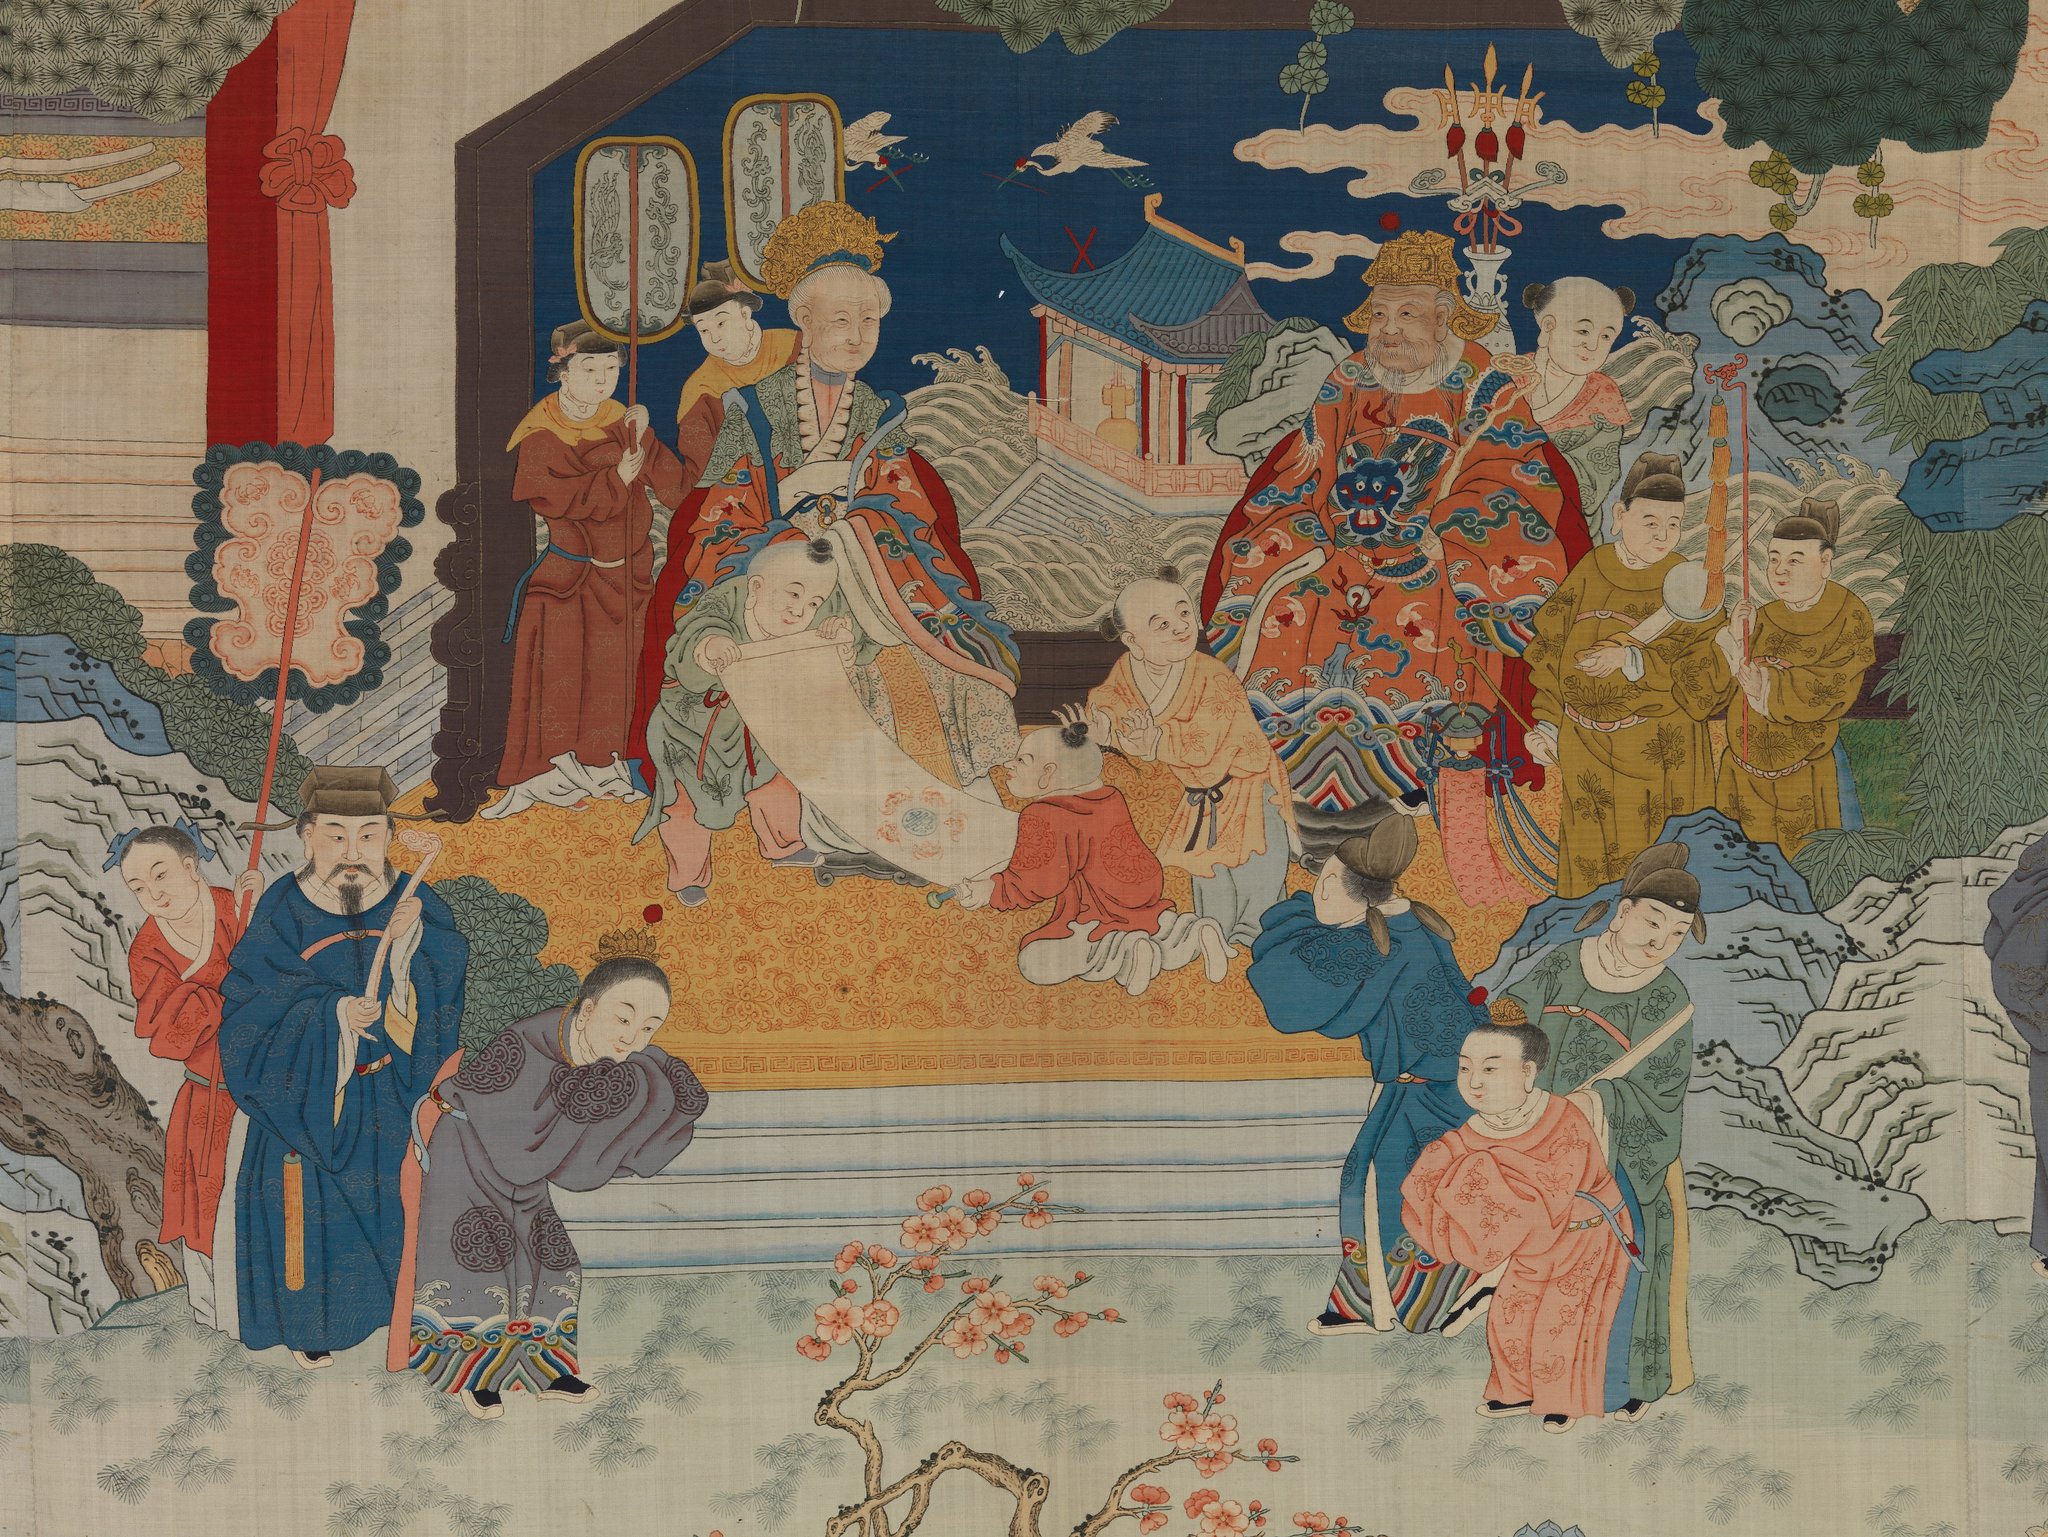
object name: panel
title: Panel with birthday celebration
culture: chinese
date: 1801-1900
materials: metal thread, silk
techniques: tapestry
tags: cranes,scrolls,children,men,women